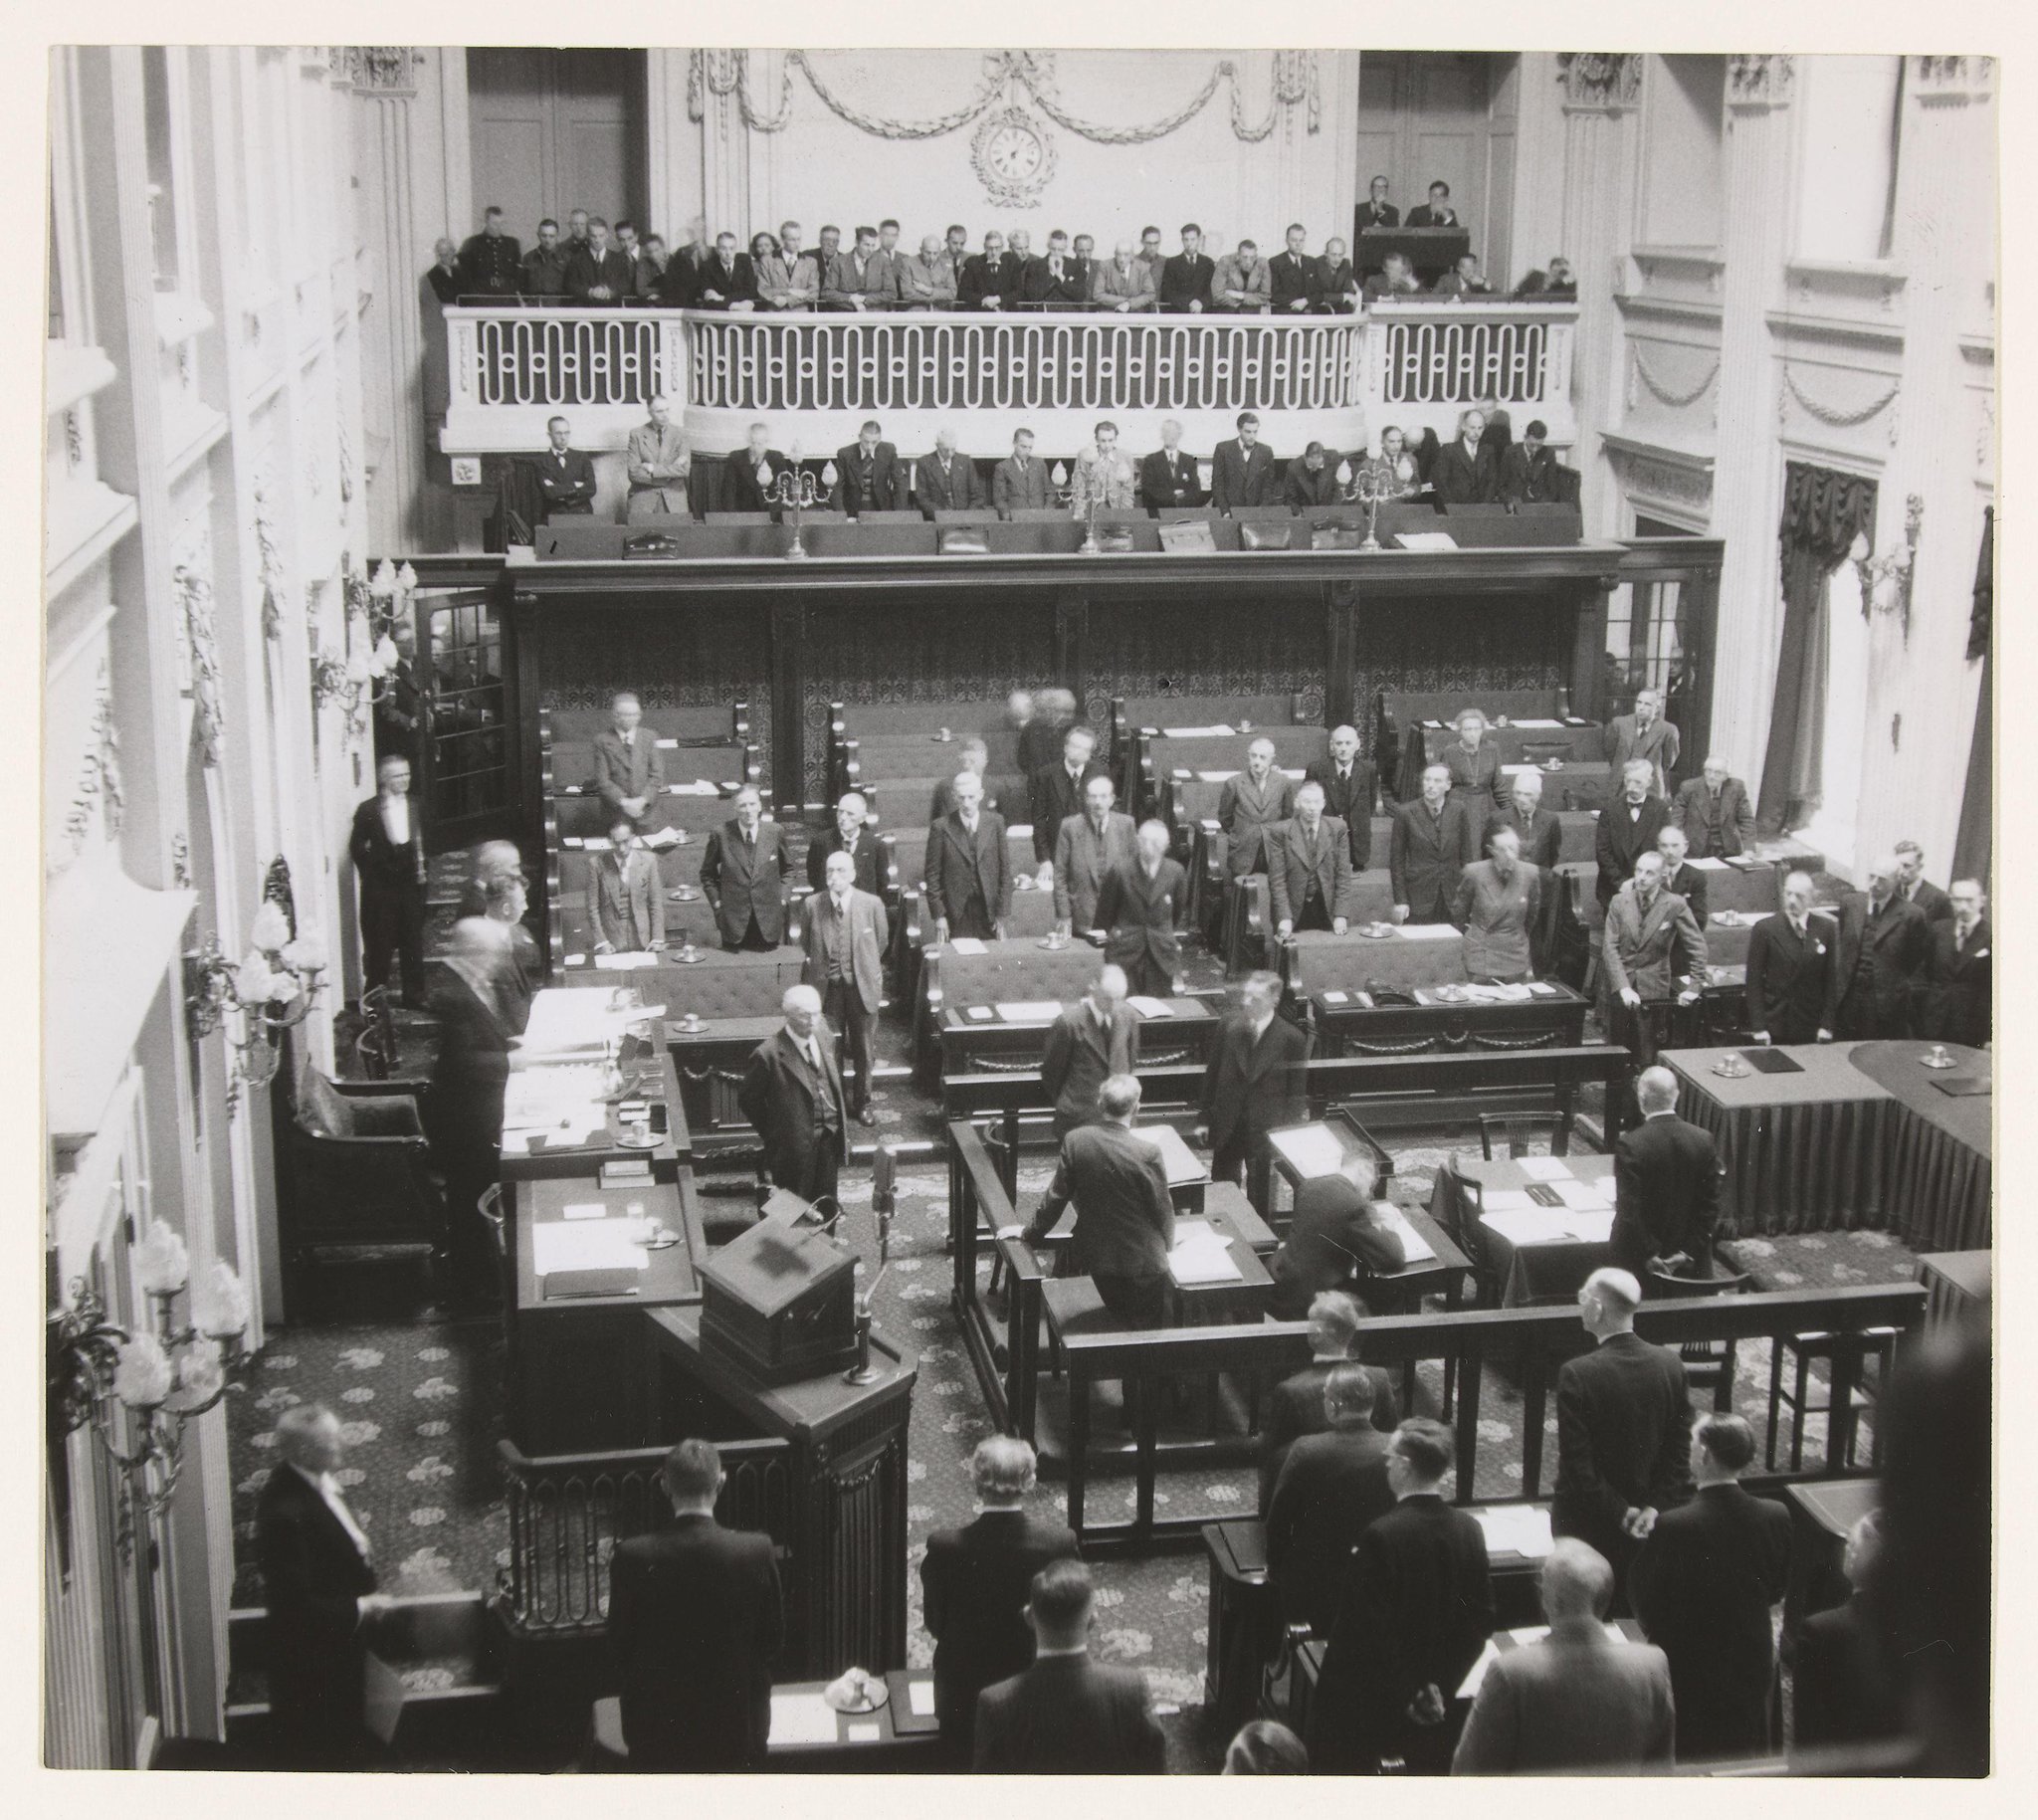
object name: documentary photograph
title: Heropening Tweede Kamer na Duitse bezetting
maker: theo van haren noman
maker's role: cineast, fotograaf, regisseur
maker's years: 1917-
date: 1945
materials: photographic support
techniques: photography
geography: the hague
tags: the hague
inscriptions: number: ‘8286’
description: Voor het eerst sinds de Duitse bezetting werd op dinsdag 25 september 1945 de Tweede Kamer der Staten Generaal weer geopend. Een vogelvluchtbeeld van een gevulde Tweede Kamer (en ook een drukke publiekstribune) tijdens de openingsrede van Tweede Kamer voorzitter Josef van Schaik.